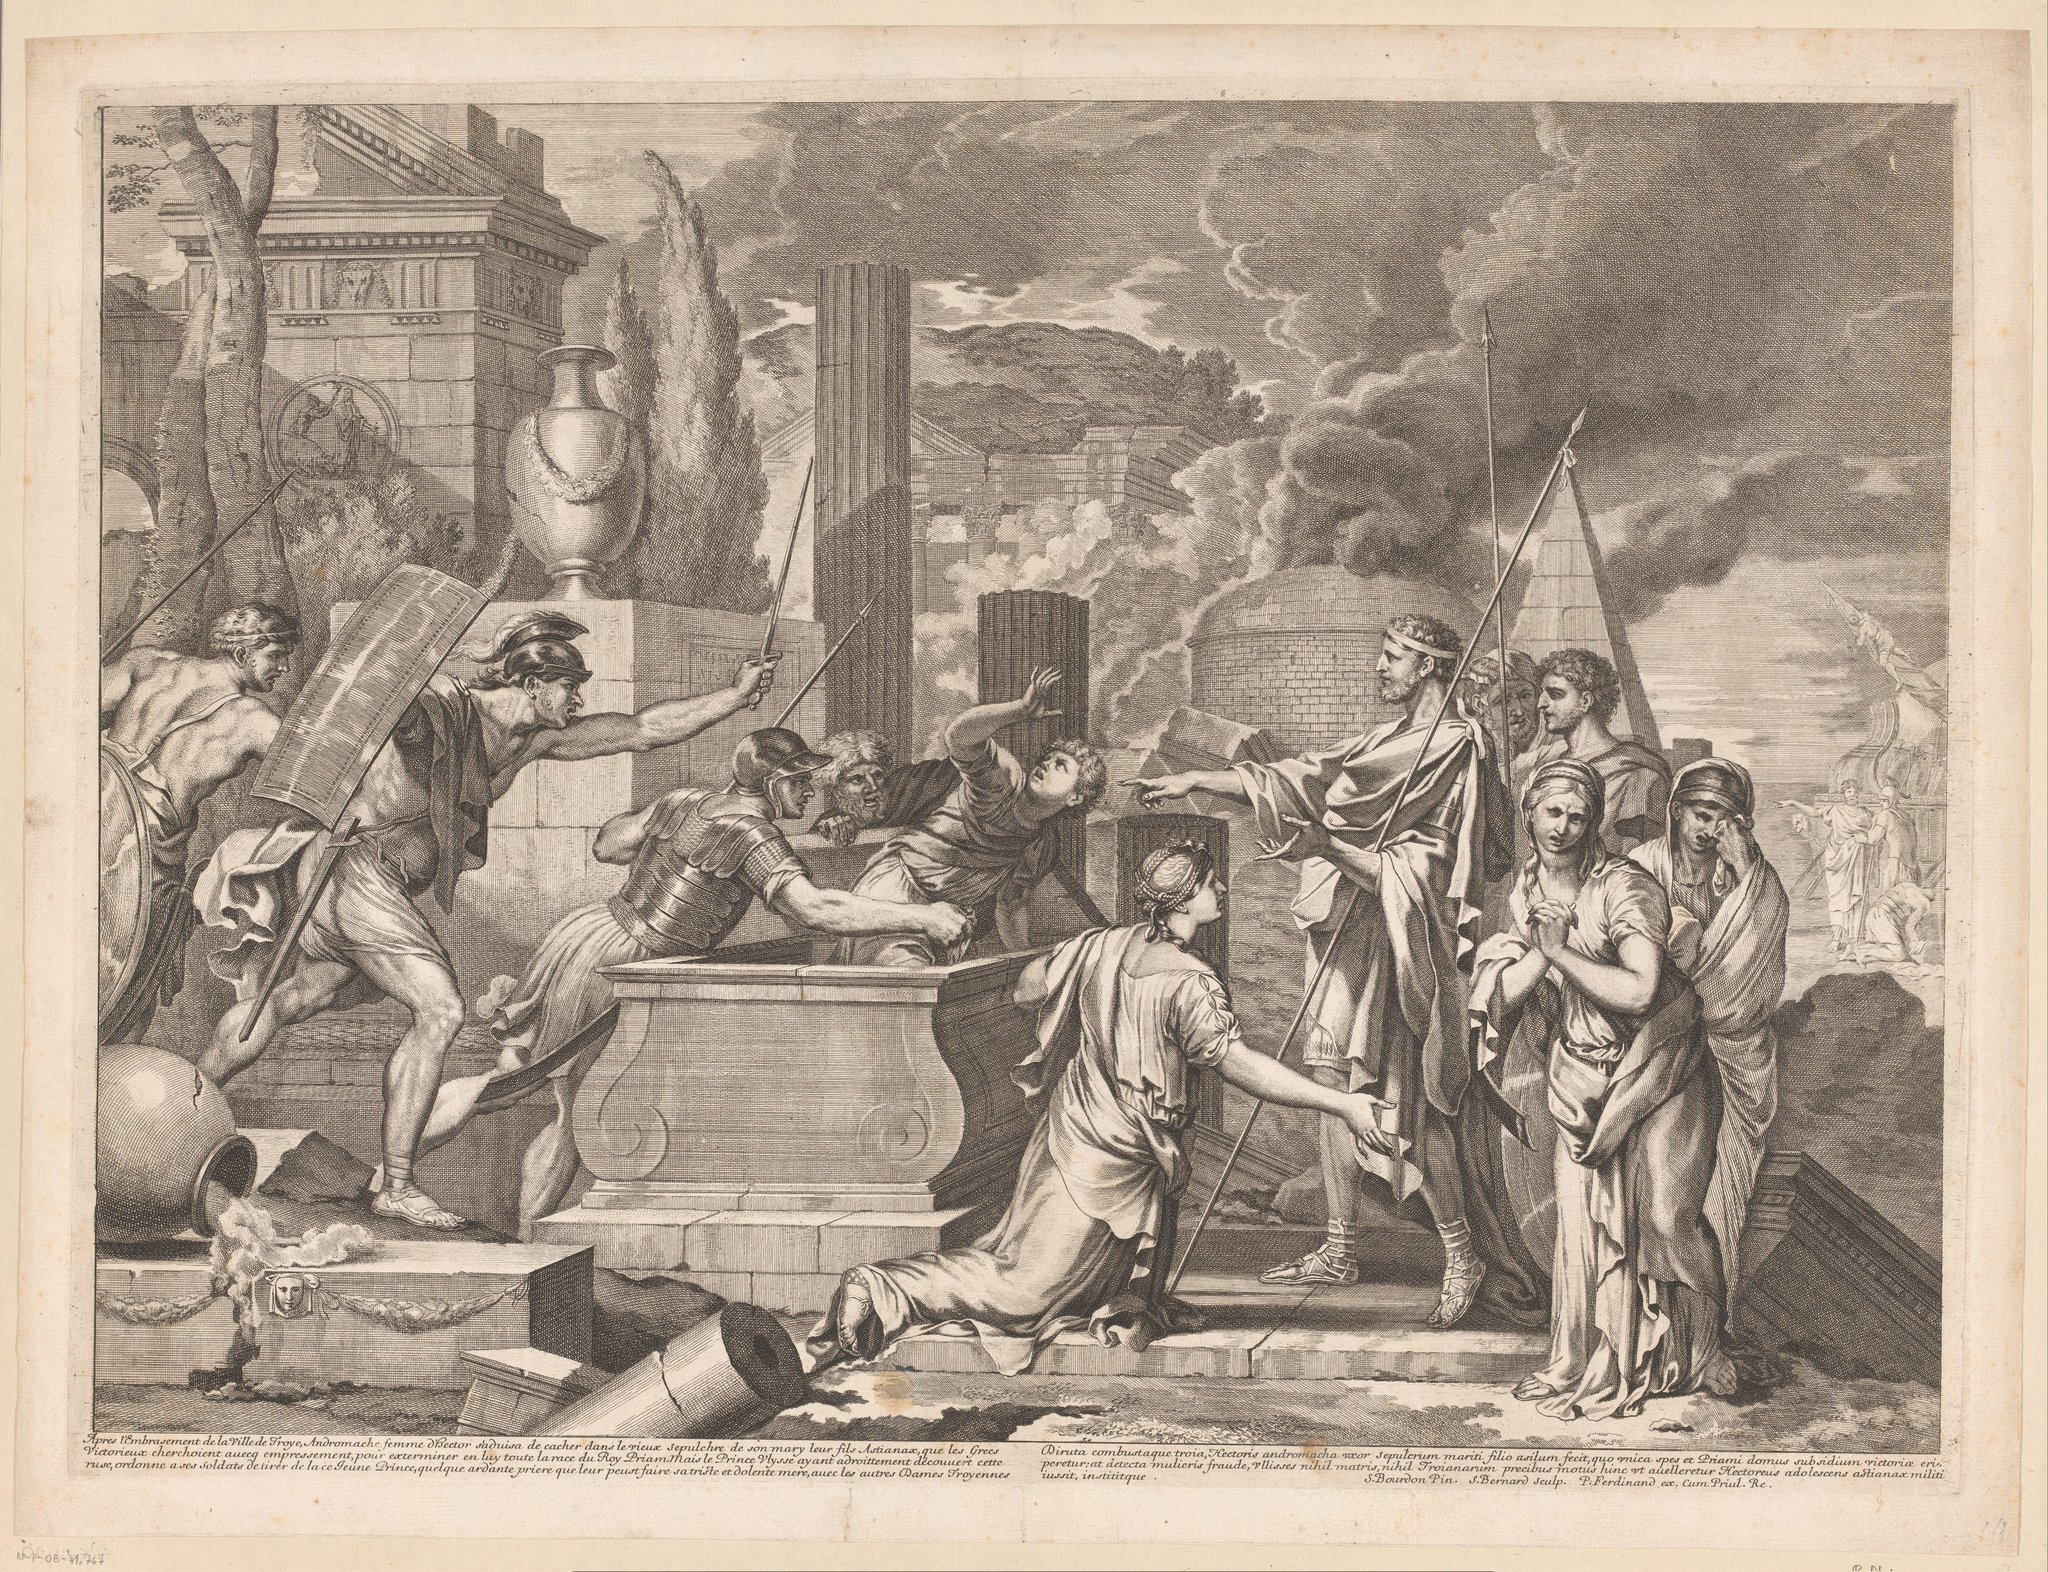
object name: print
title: Astyanax ontdekt door Odysseus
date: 1627-1655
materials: paper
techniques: engraving, etching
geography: france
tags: (story of) ulysses, astyanax is snatched away from andromache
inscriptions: collector's mark: Lugt 240